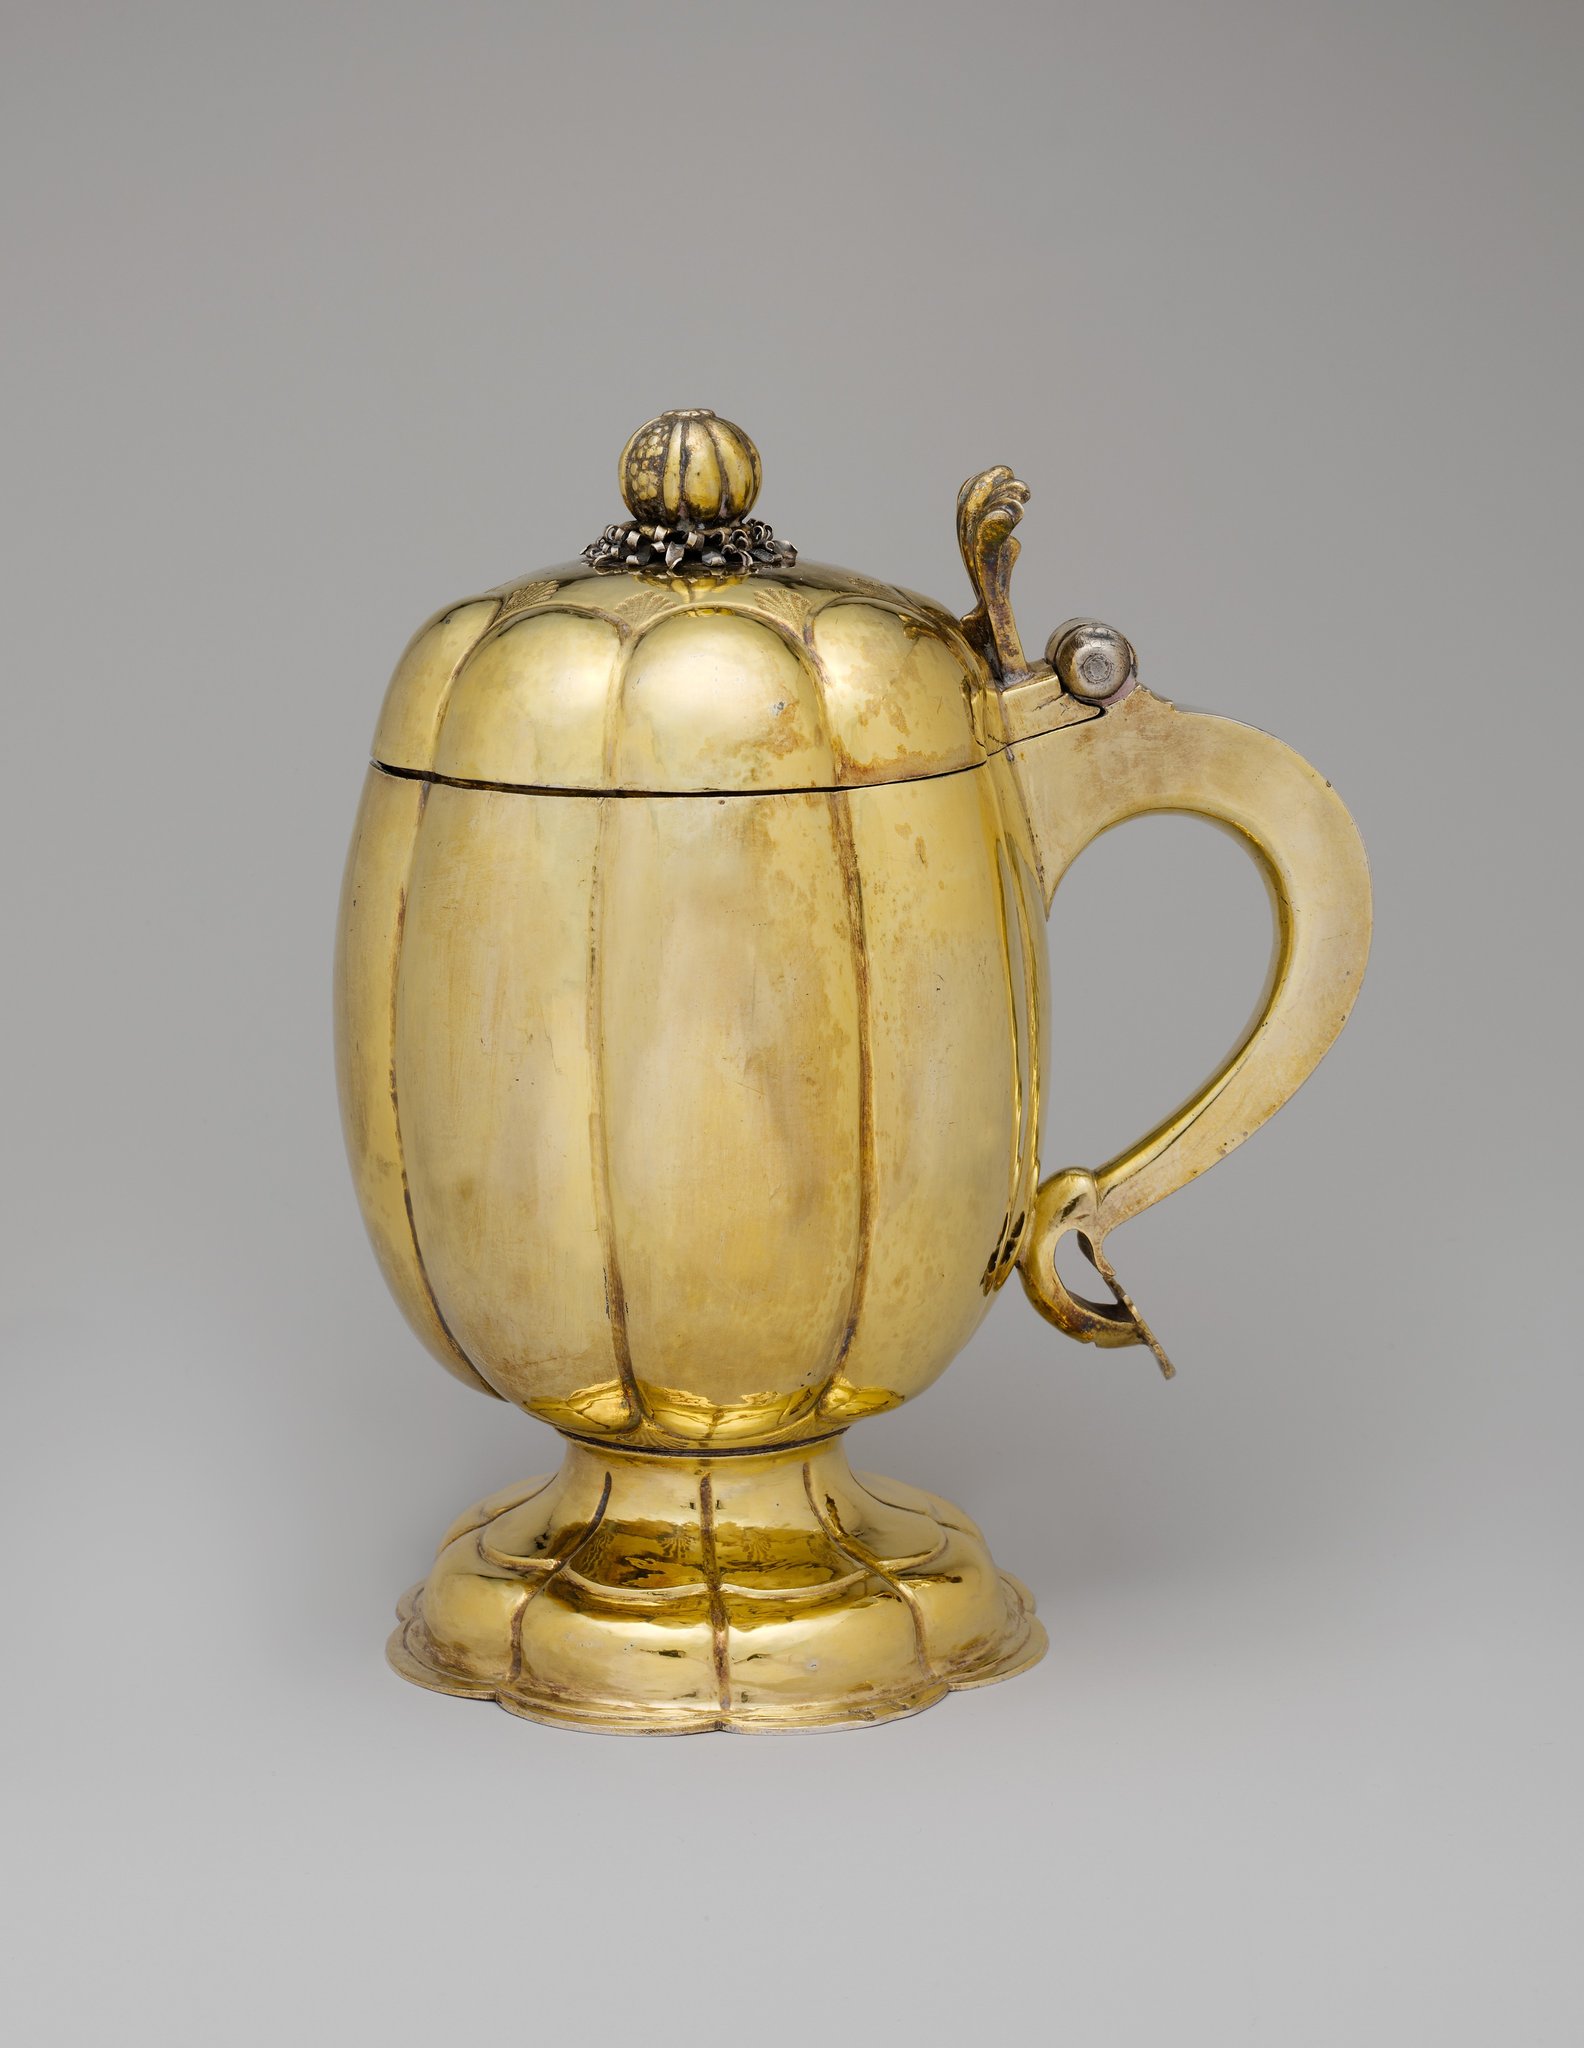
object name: tankard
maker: ludwig wachman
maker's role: maker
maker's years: 1632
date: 1640-1650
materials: silver gilt